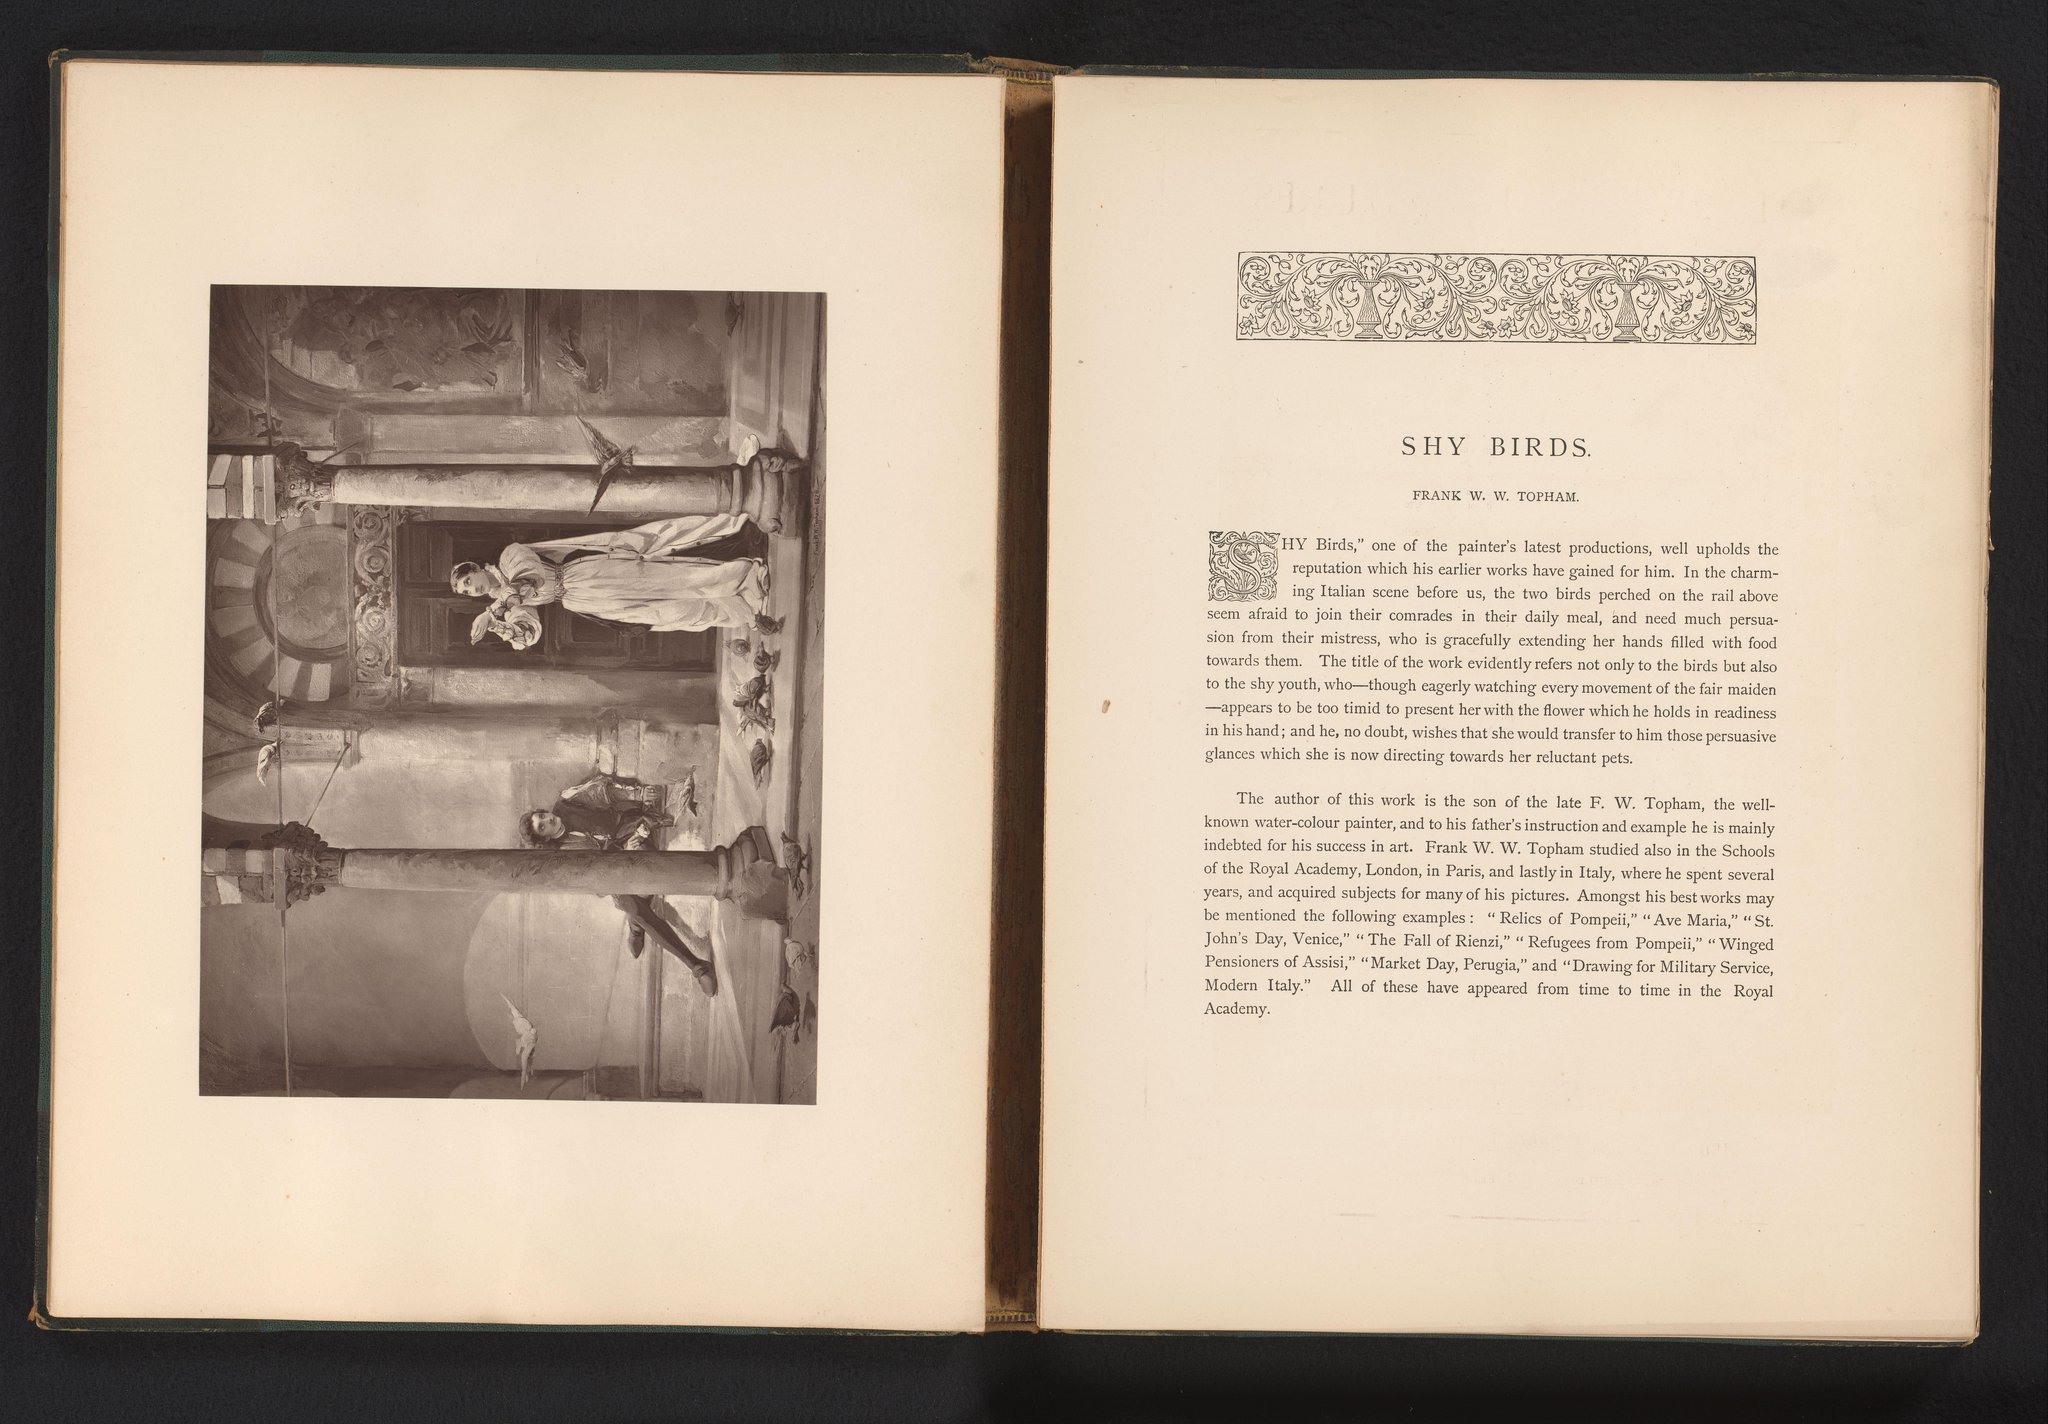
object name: photomechanical print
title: Reproductie van een schilderij van een vrouw die vogels voert door Francis William Topham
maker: Anonymous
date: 1874-1879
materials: paper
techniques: woodburytype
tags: feeding wild animals, doves, pigeons